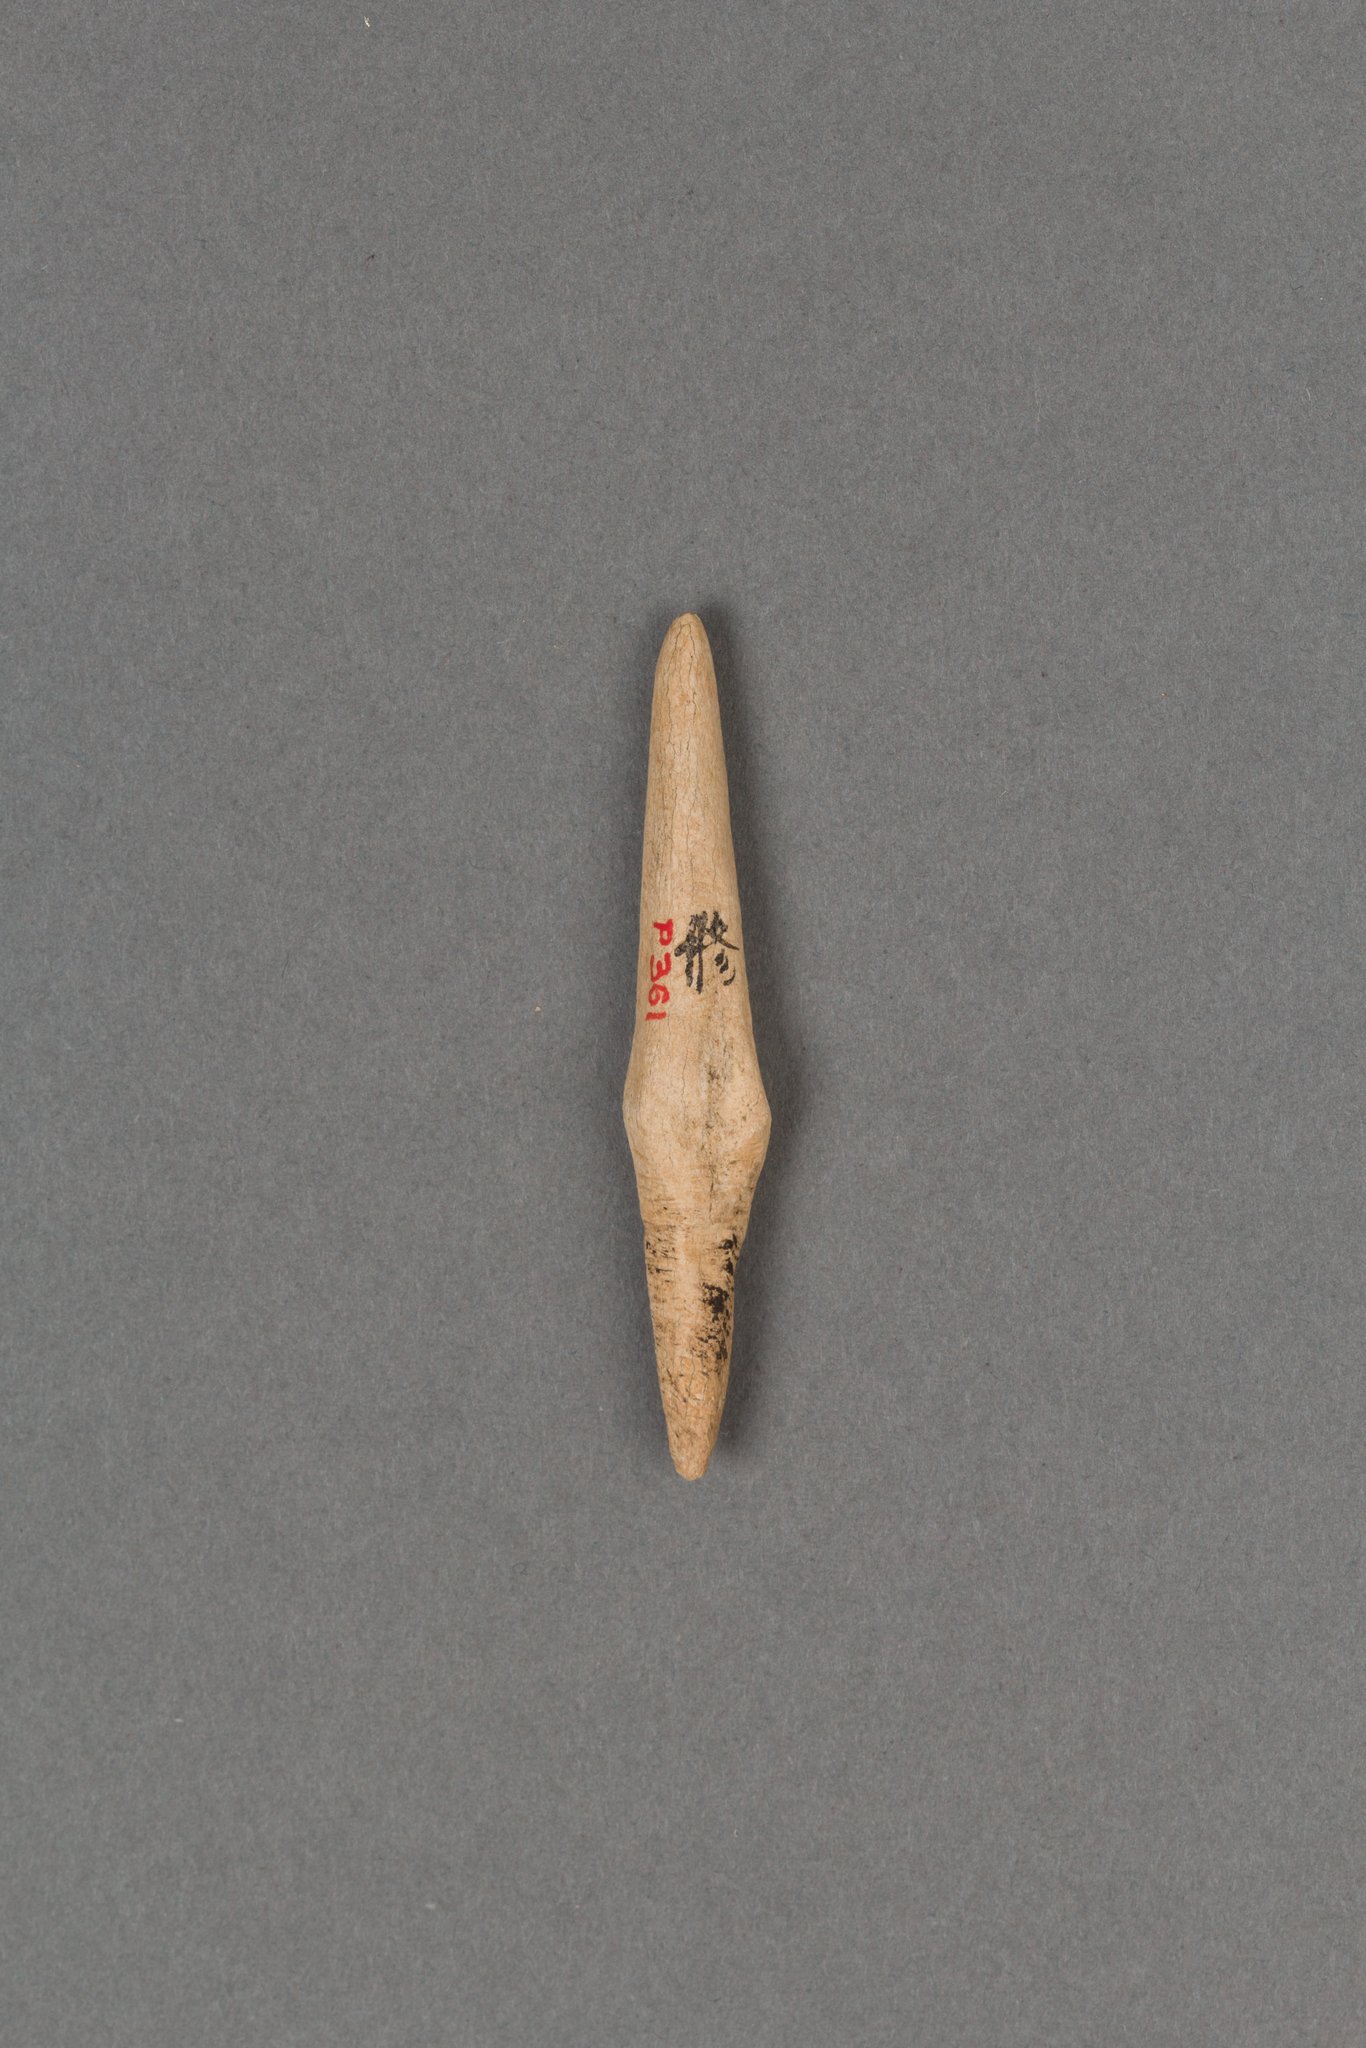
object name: arrowhead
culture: japanese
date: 1200-200 BCE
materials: bone